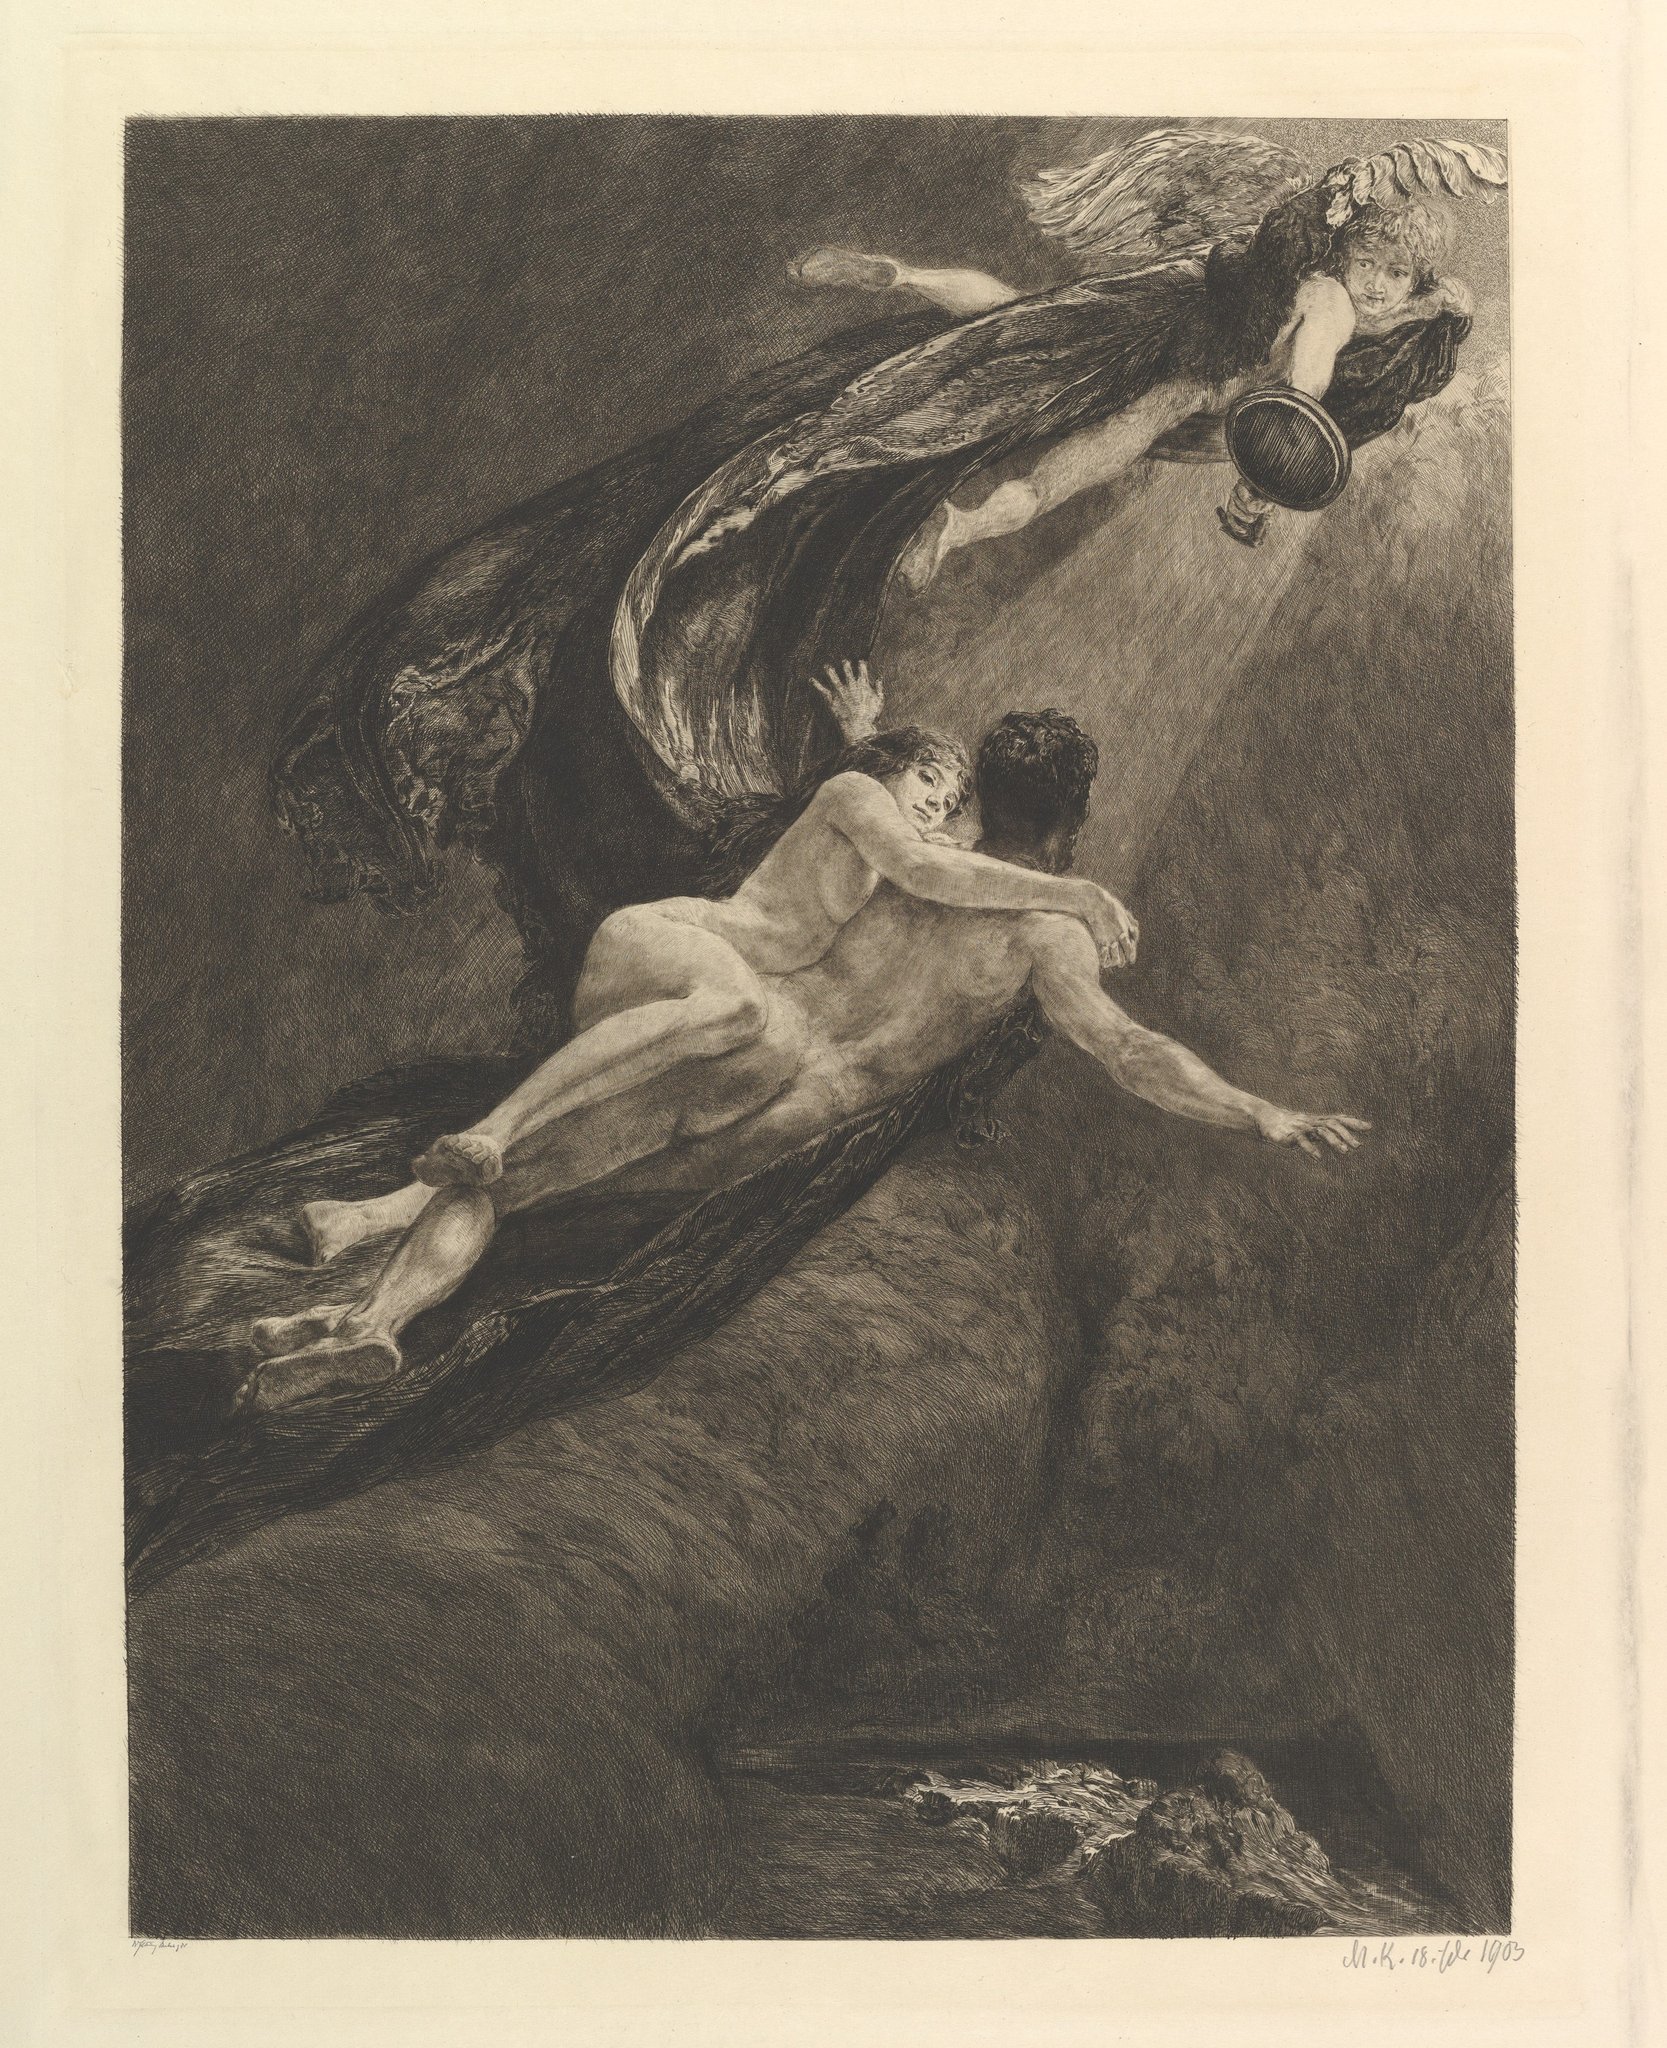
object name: print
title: New Dreams of Happiness (from the series A Love)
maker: max klinger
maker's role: artist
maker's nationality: german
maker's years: 1857-1920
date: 1887-1903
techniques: engraving, etching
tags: male nudes,female nudes,angels